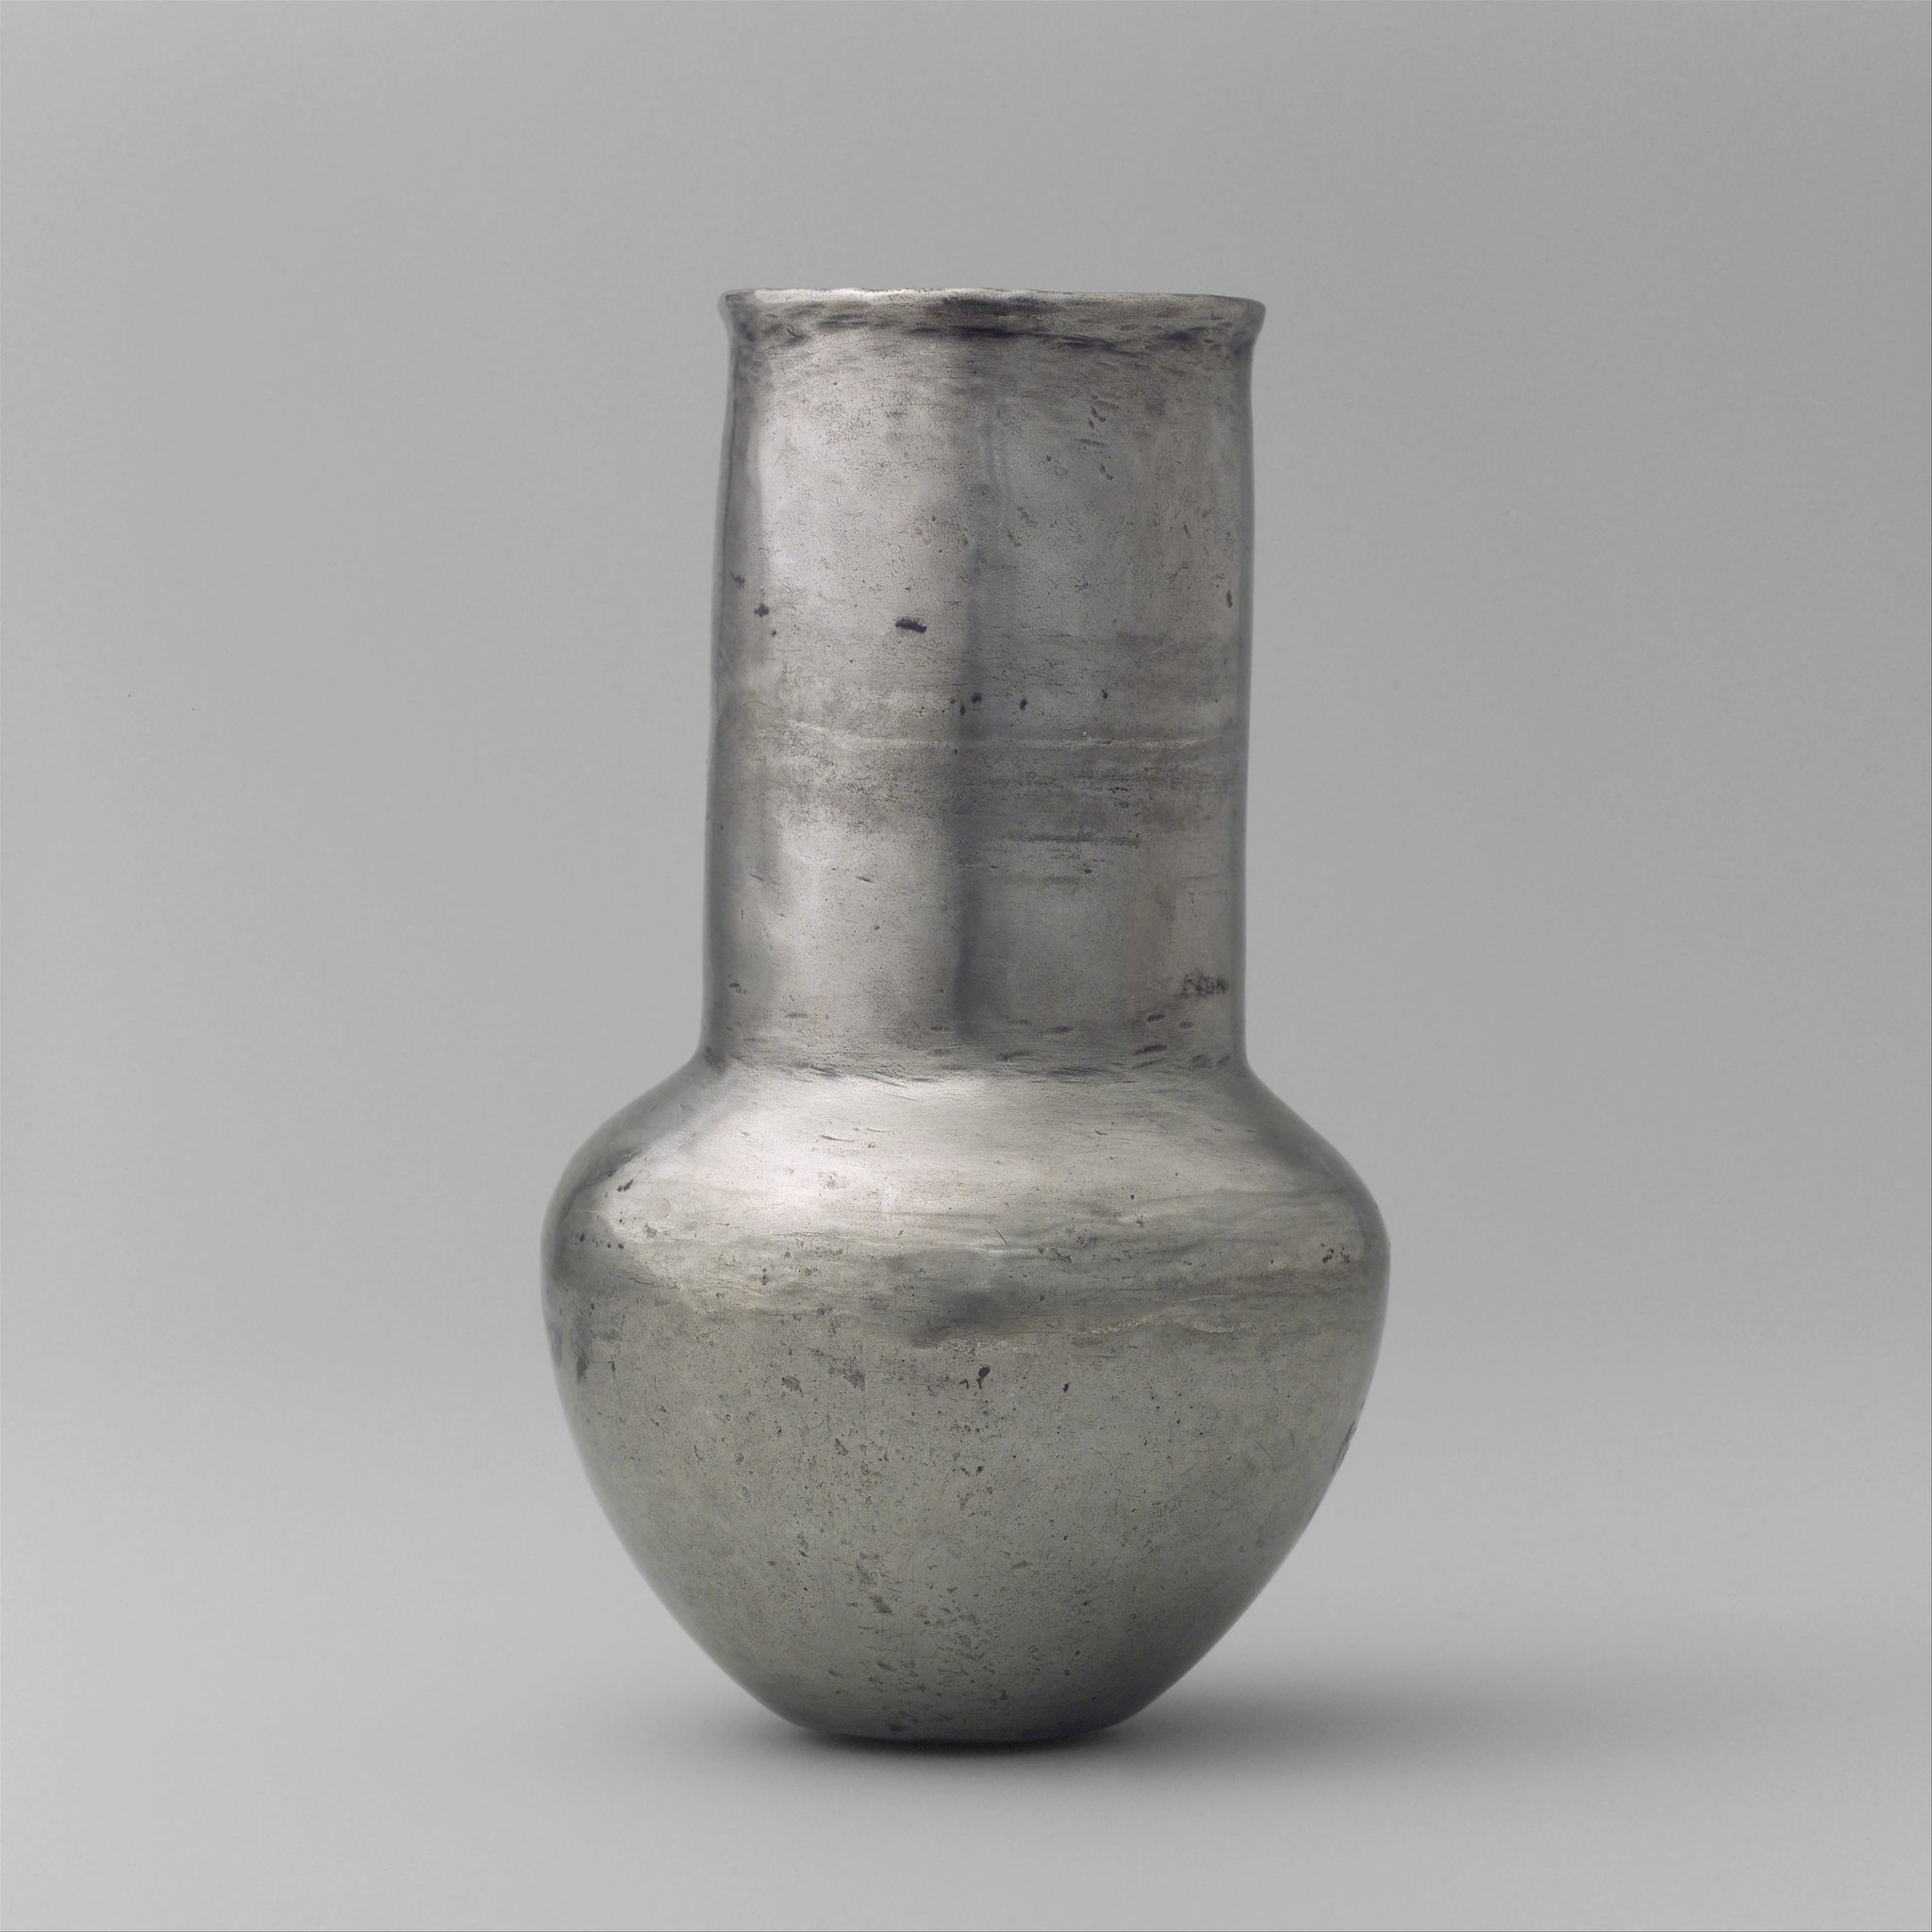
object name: jar, long necked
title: Long-necked jar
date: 1279-1213 BCE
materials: silver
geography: egypt